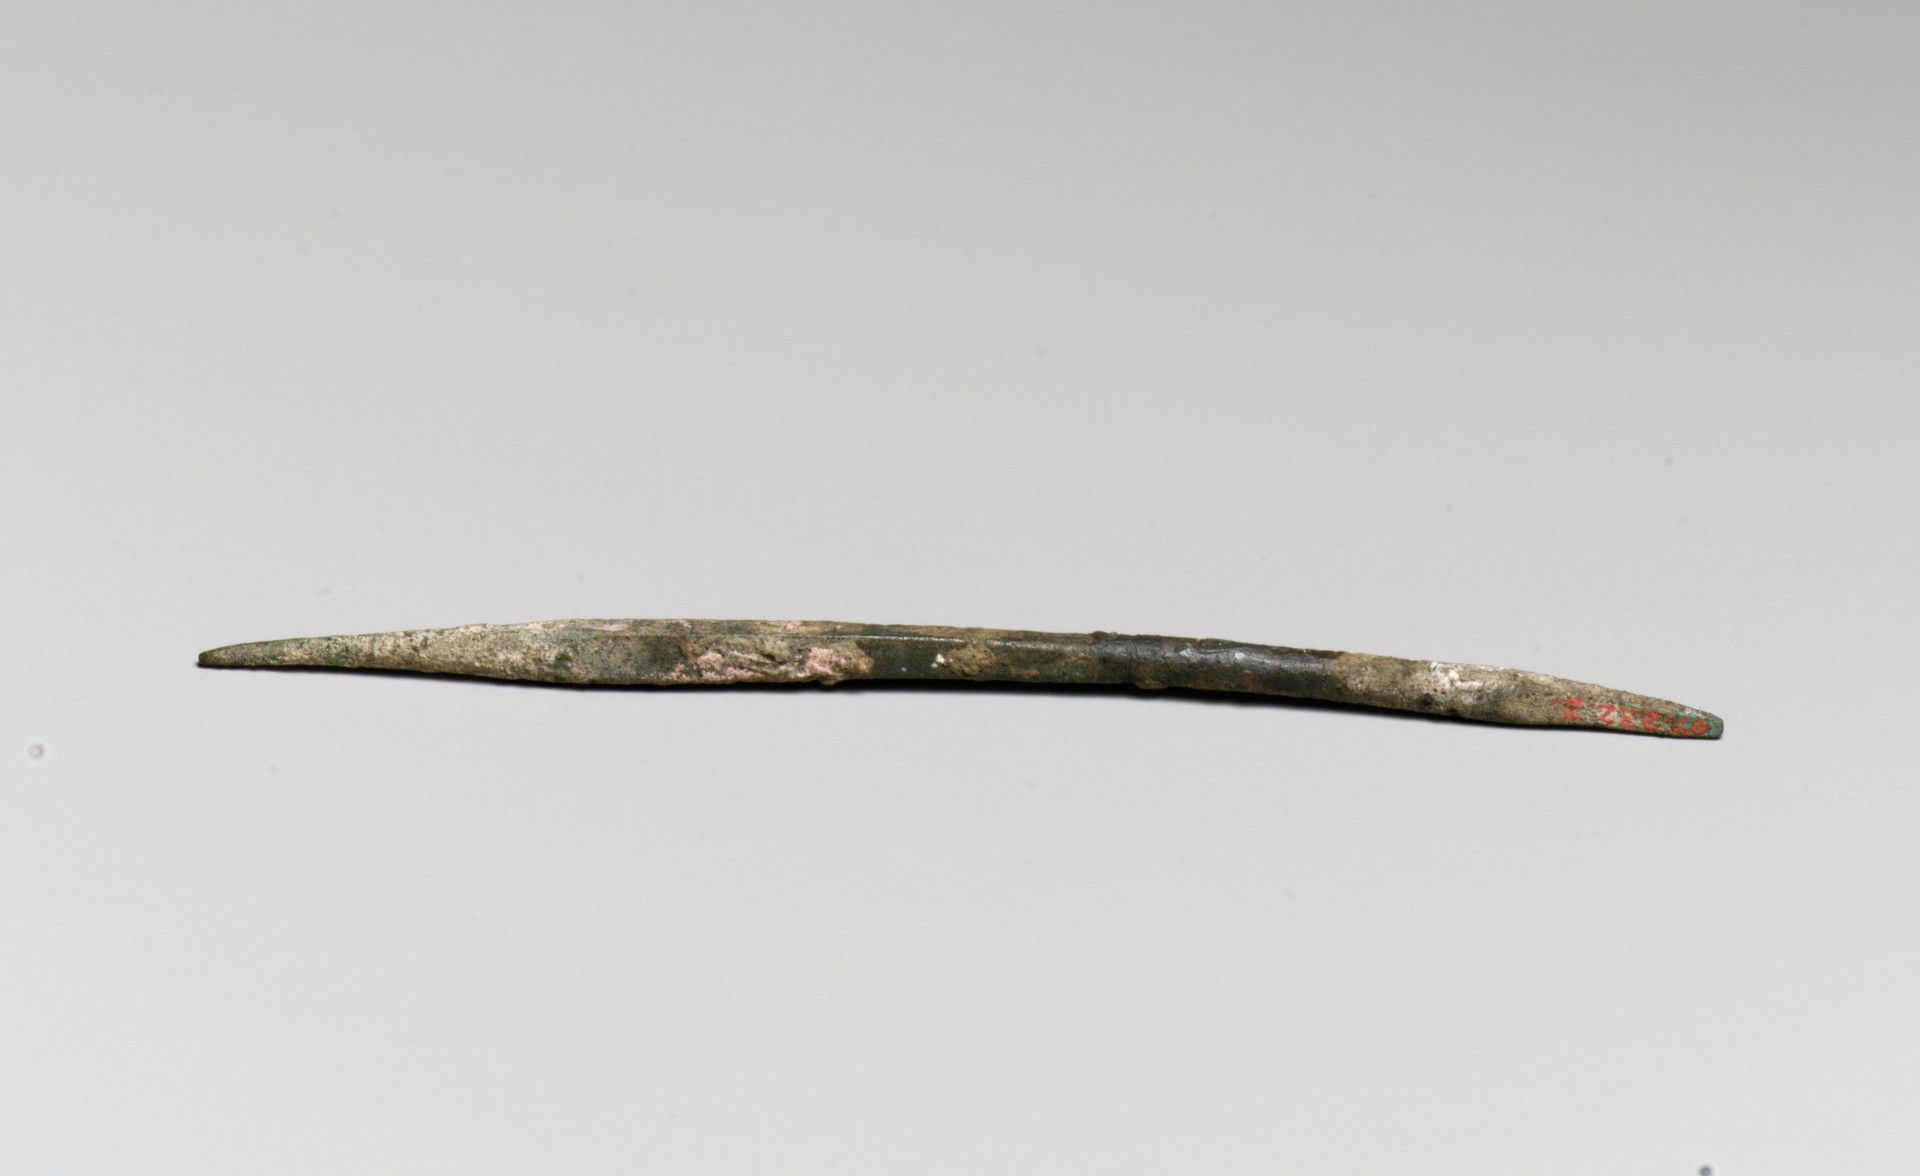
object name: awl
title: Bronze punch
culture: minoan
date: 3000-1050 BCE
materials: bronze